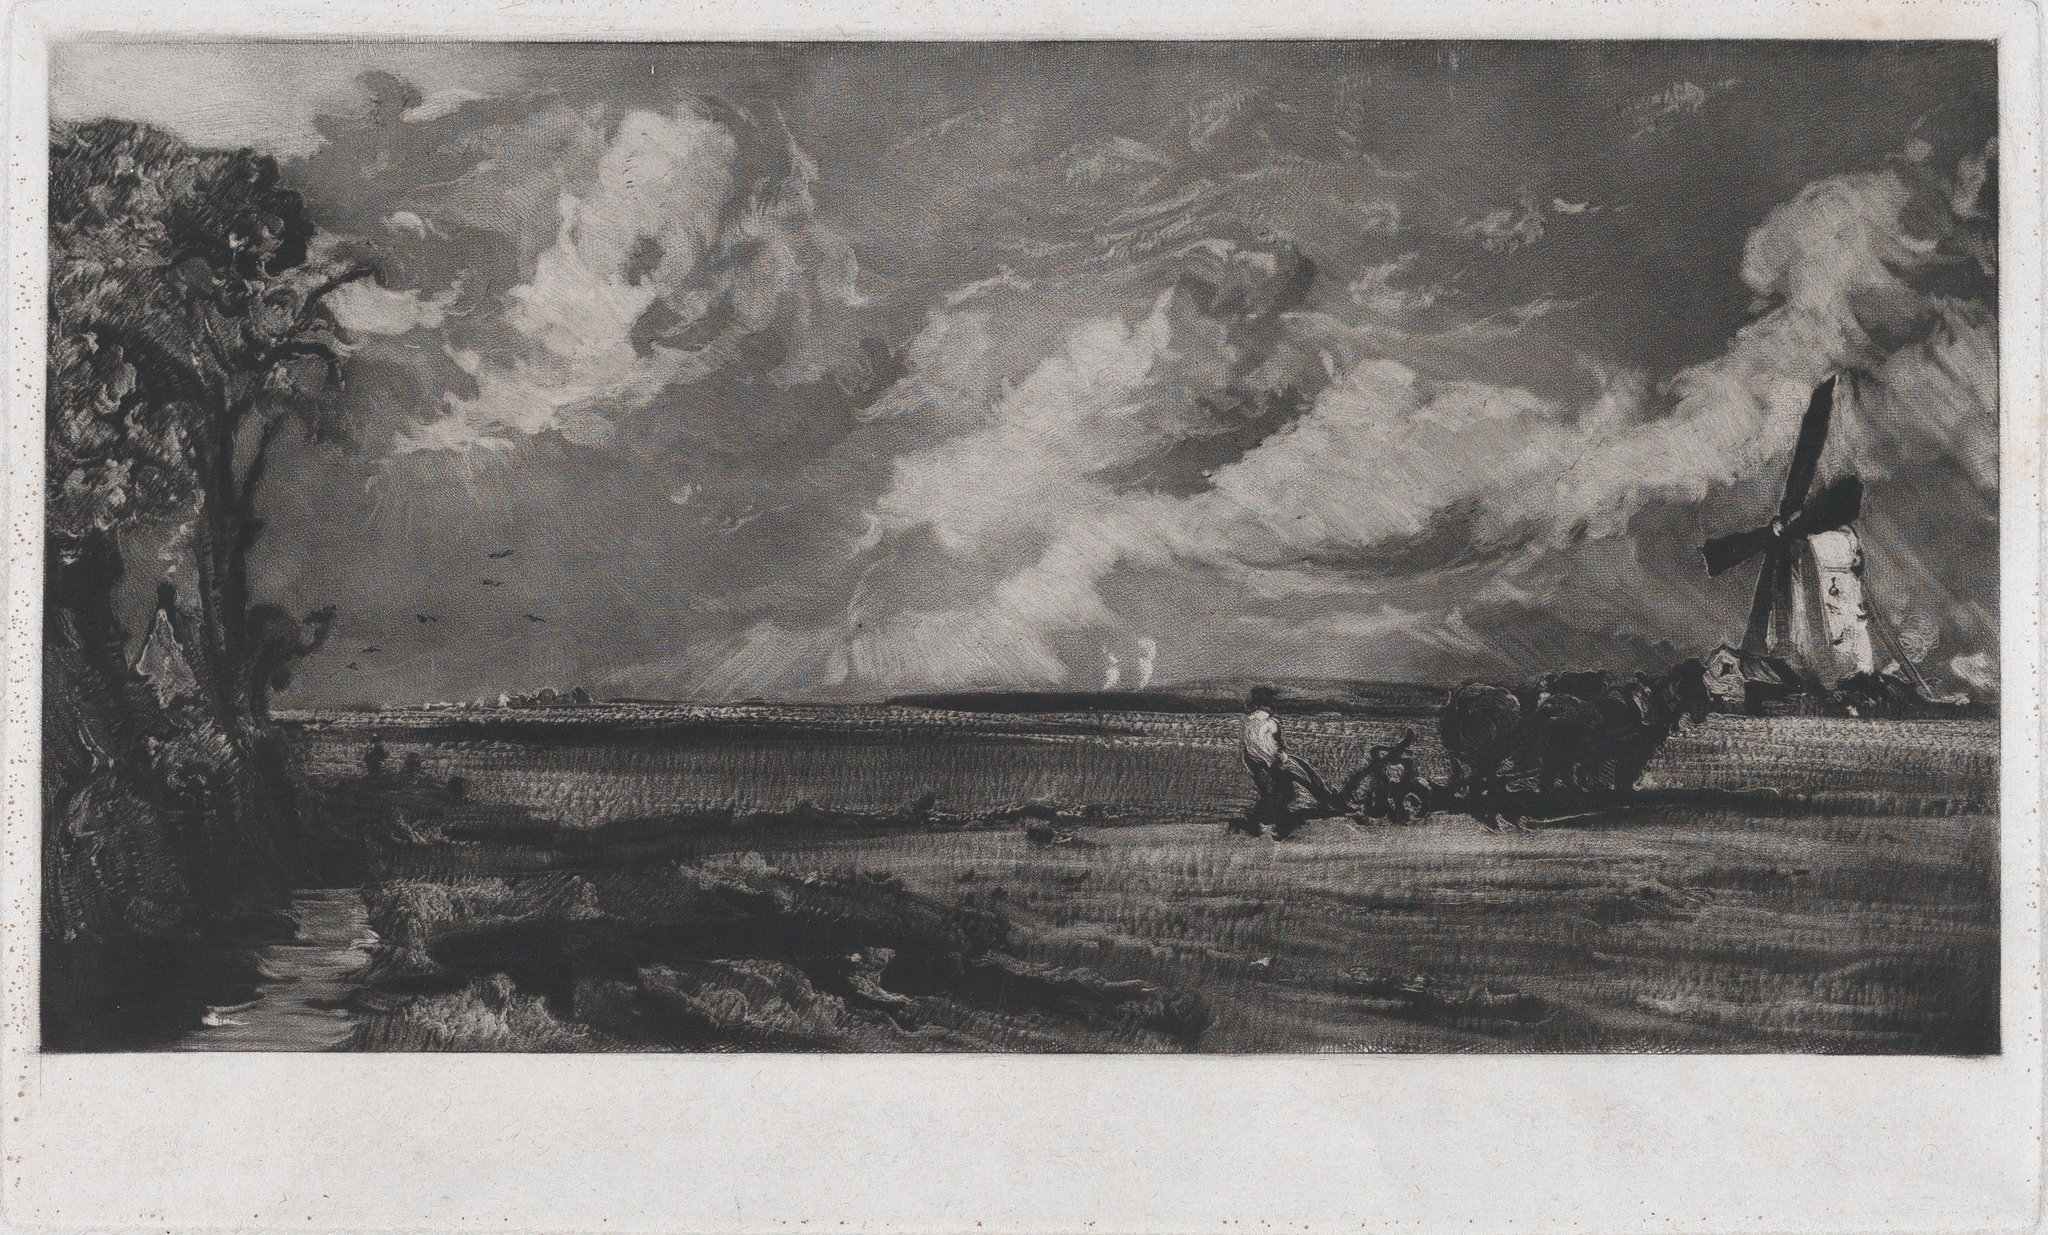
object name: print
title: Spring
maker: david lucas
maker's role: artist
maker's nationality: british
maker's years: 1802-1881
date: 1829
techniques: mezzotint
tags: windmills,horses,landscapes,spring,farmers